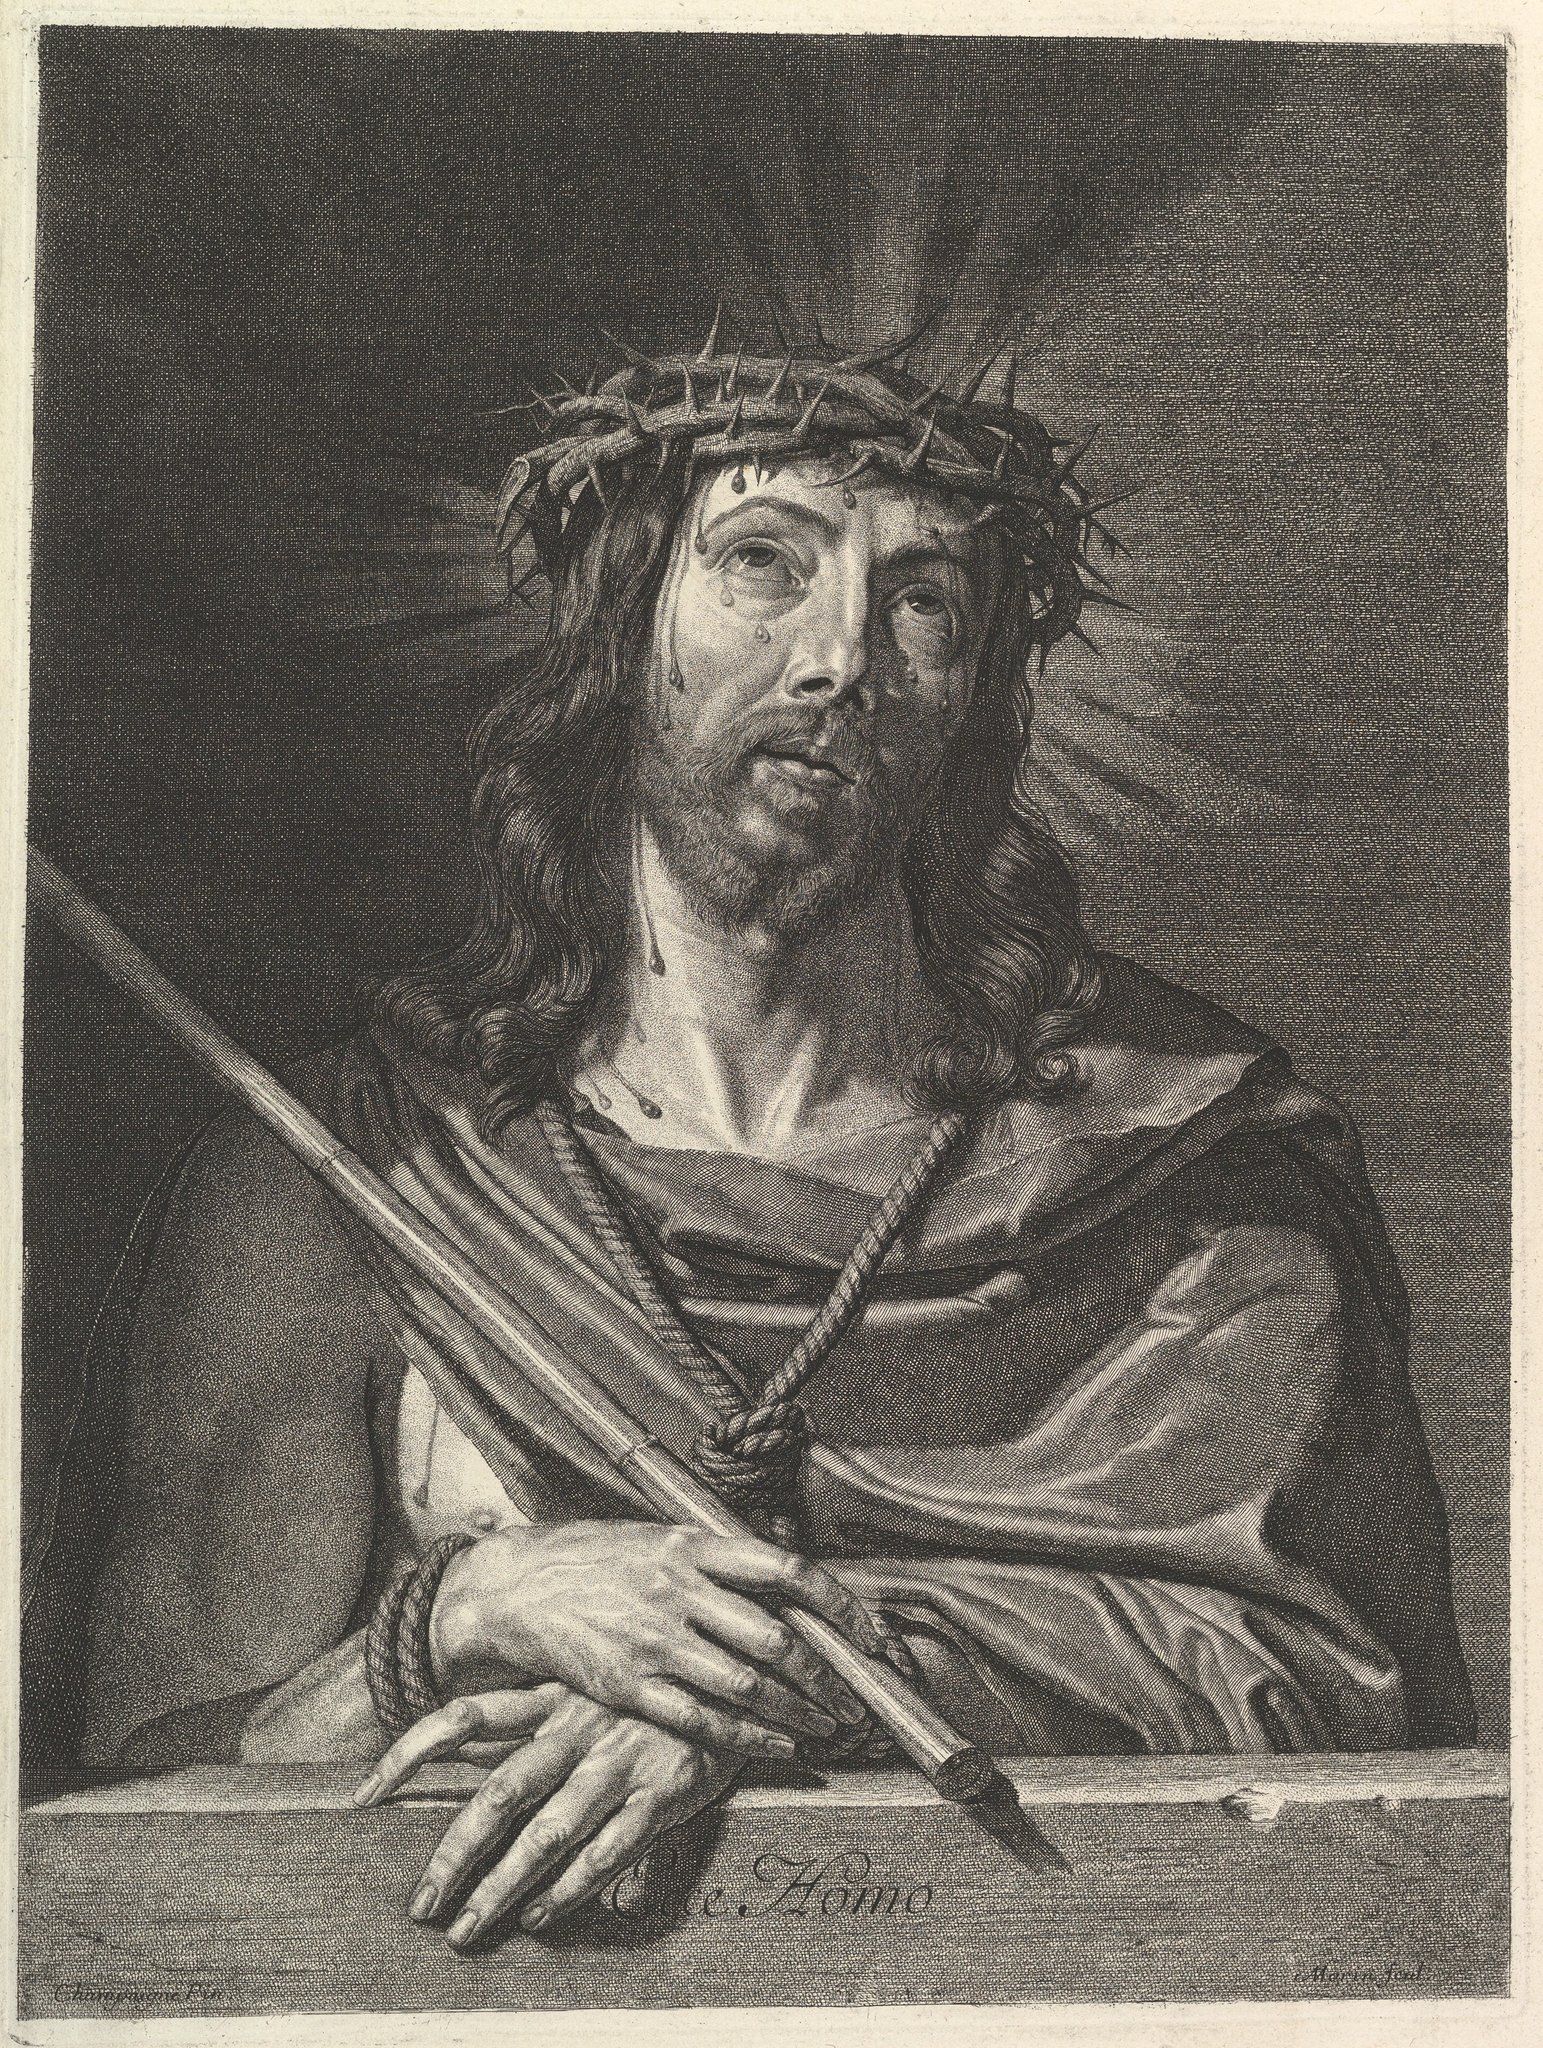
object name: print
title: L'Ecce Homo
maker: jean morin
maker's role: artist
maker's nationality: french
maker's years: 1605-1650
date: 1605-1650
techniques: etching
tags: suffering,christ